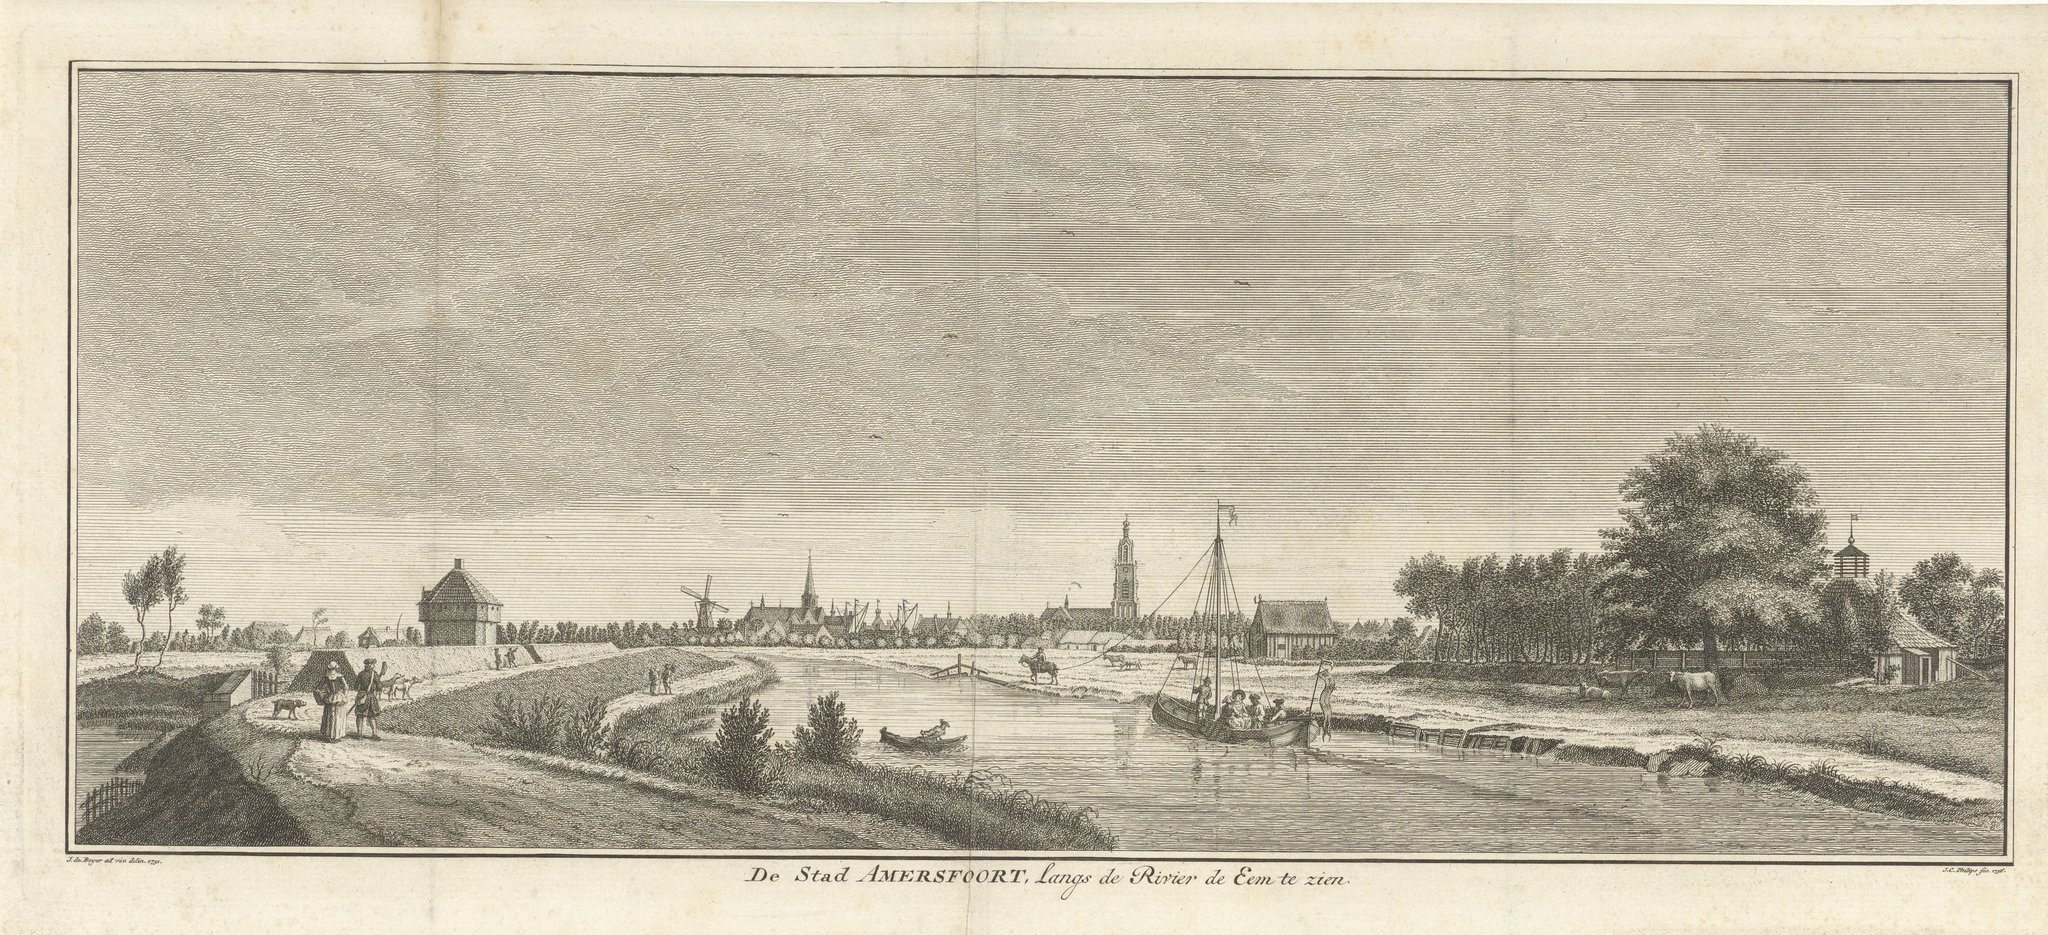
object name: print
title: Gezicht op Amersfoort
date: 1756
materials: paper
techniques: etching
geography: amsterdam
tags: city-view in general; 'veduta'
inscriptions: collector's mark: Lugt 2228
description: Prent ook gebruikt als illustratie in: Wagenaar, Jan. Hedendaagsche historie, of Tegenwoordige staat van alle volken; XXI. deel, vervolgende den tegenwoordigen staat der Vereenigde Nederlanden, en vervattende in't byzonder die van Utrecht. Amsterdam: Isaak Tirion, 1758.